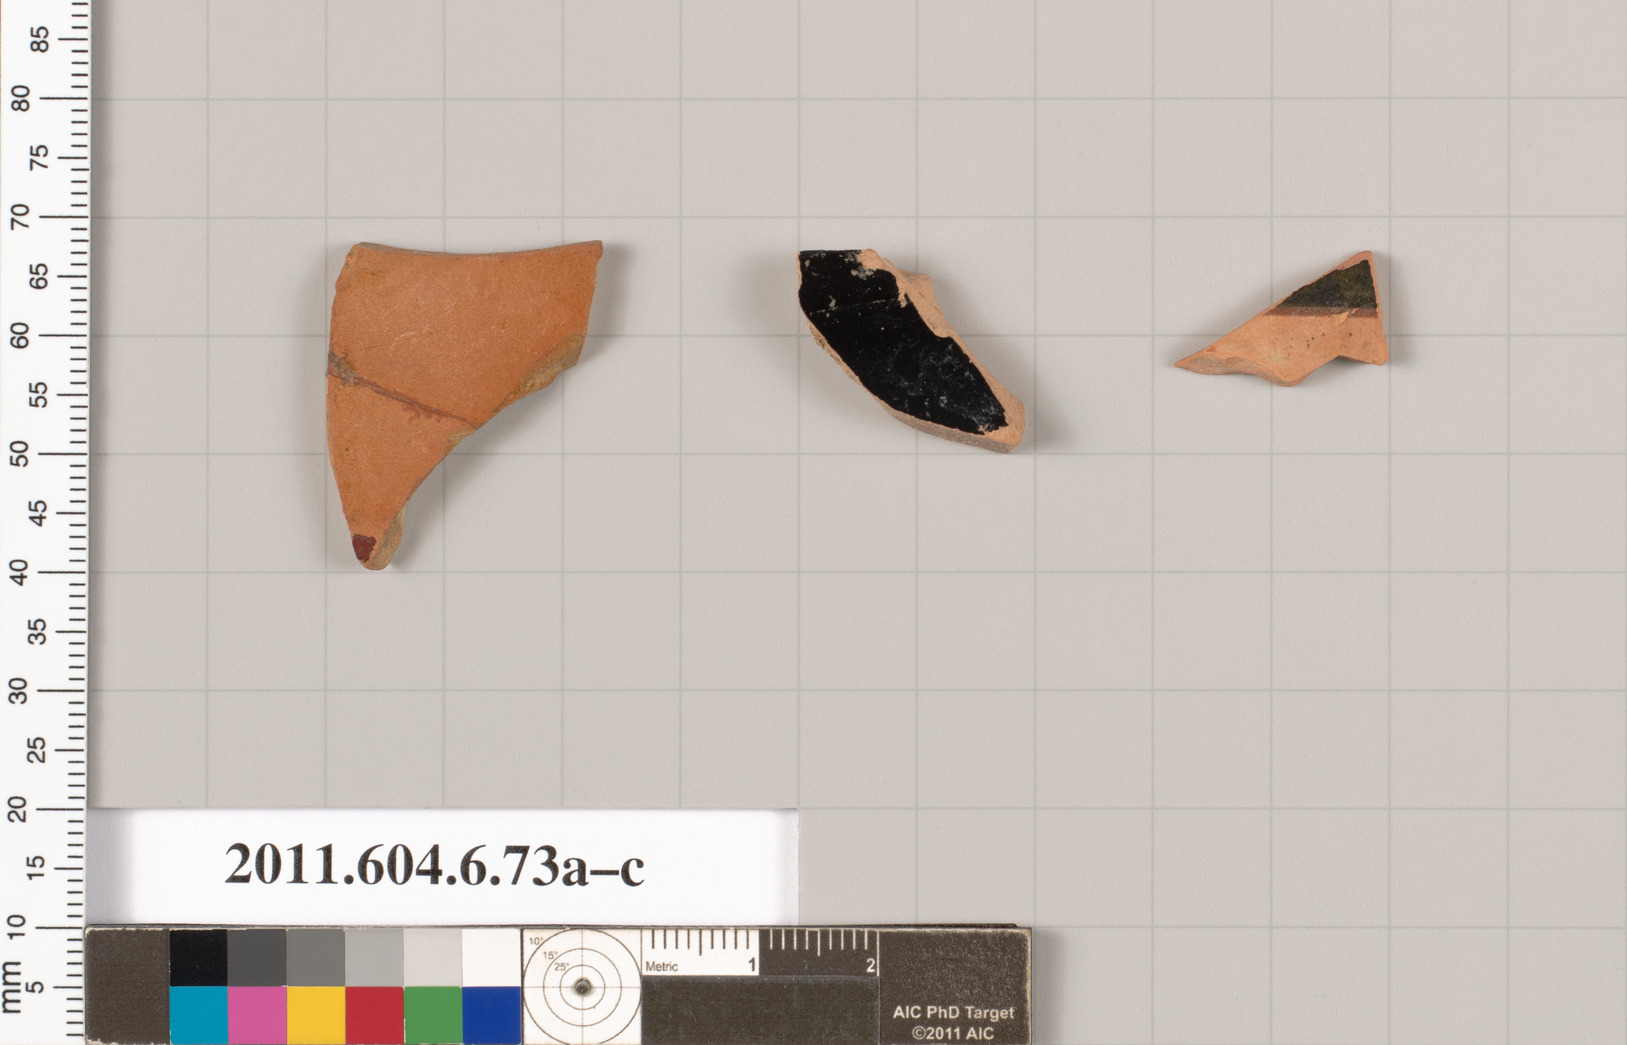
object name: undetermined closed shape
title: Terracotta fragments of closed shapes?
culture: greek, attic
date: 600-401 BCE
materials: terracotta